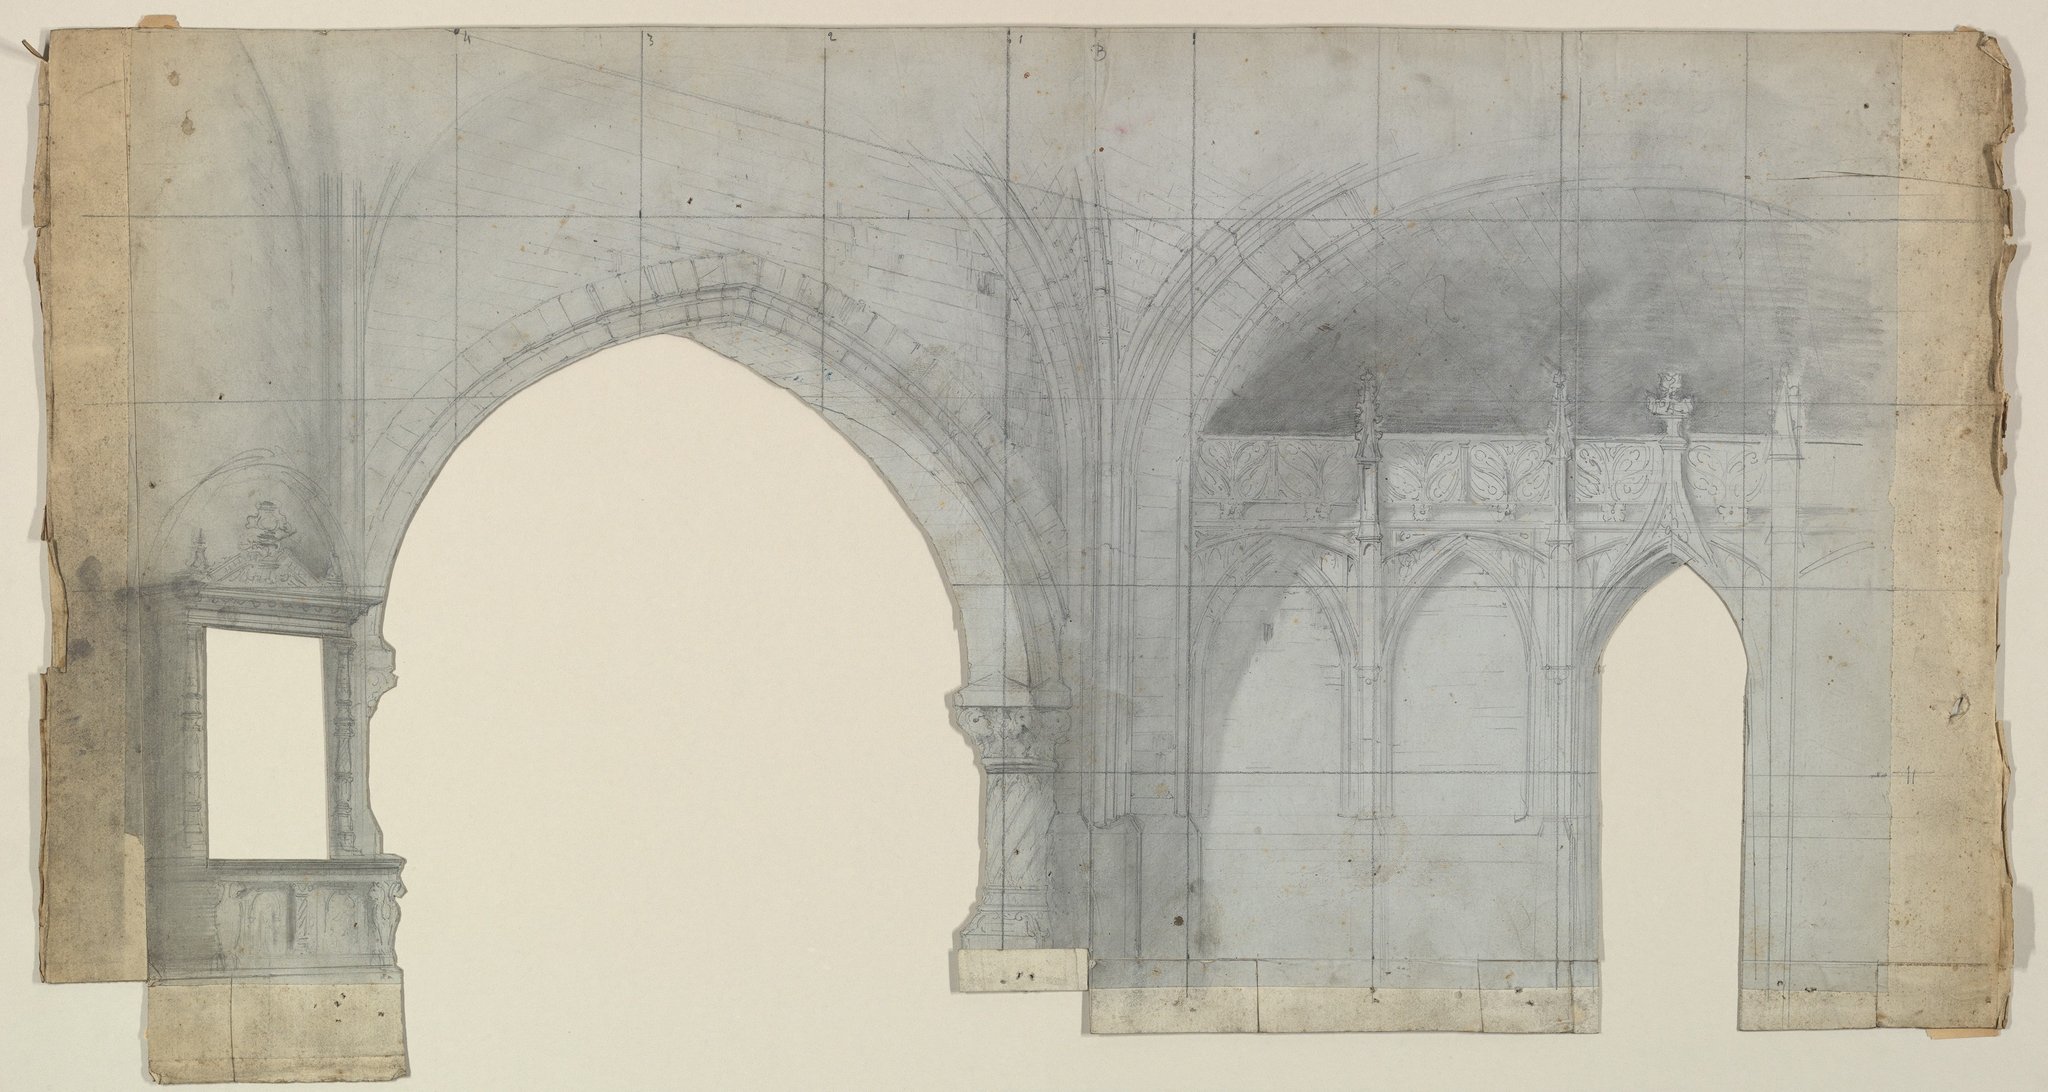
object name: drawing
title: Design for a Stage Set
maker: eugène cicéri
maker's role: artist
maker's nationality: french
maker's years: 1813-1890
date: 1830-1890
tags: arches,stage design